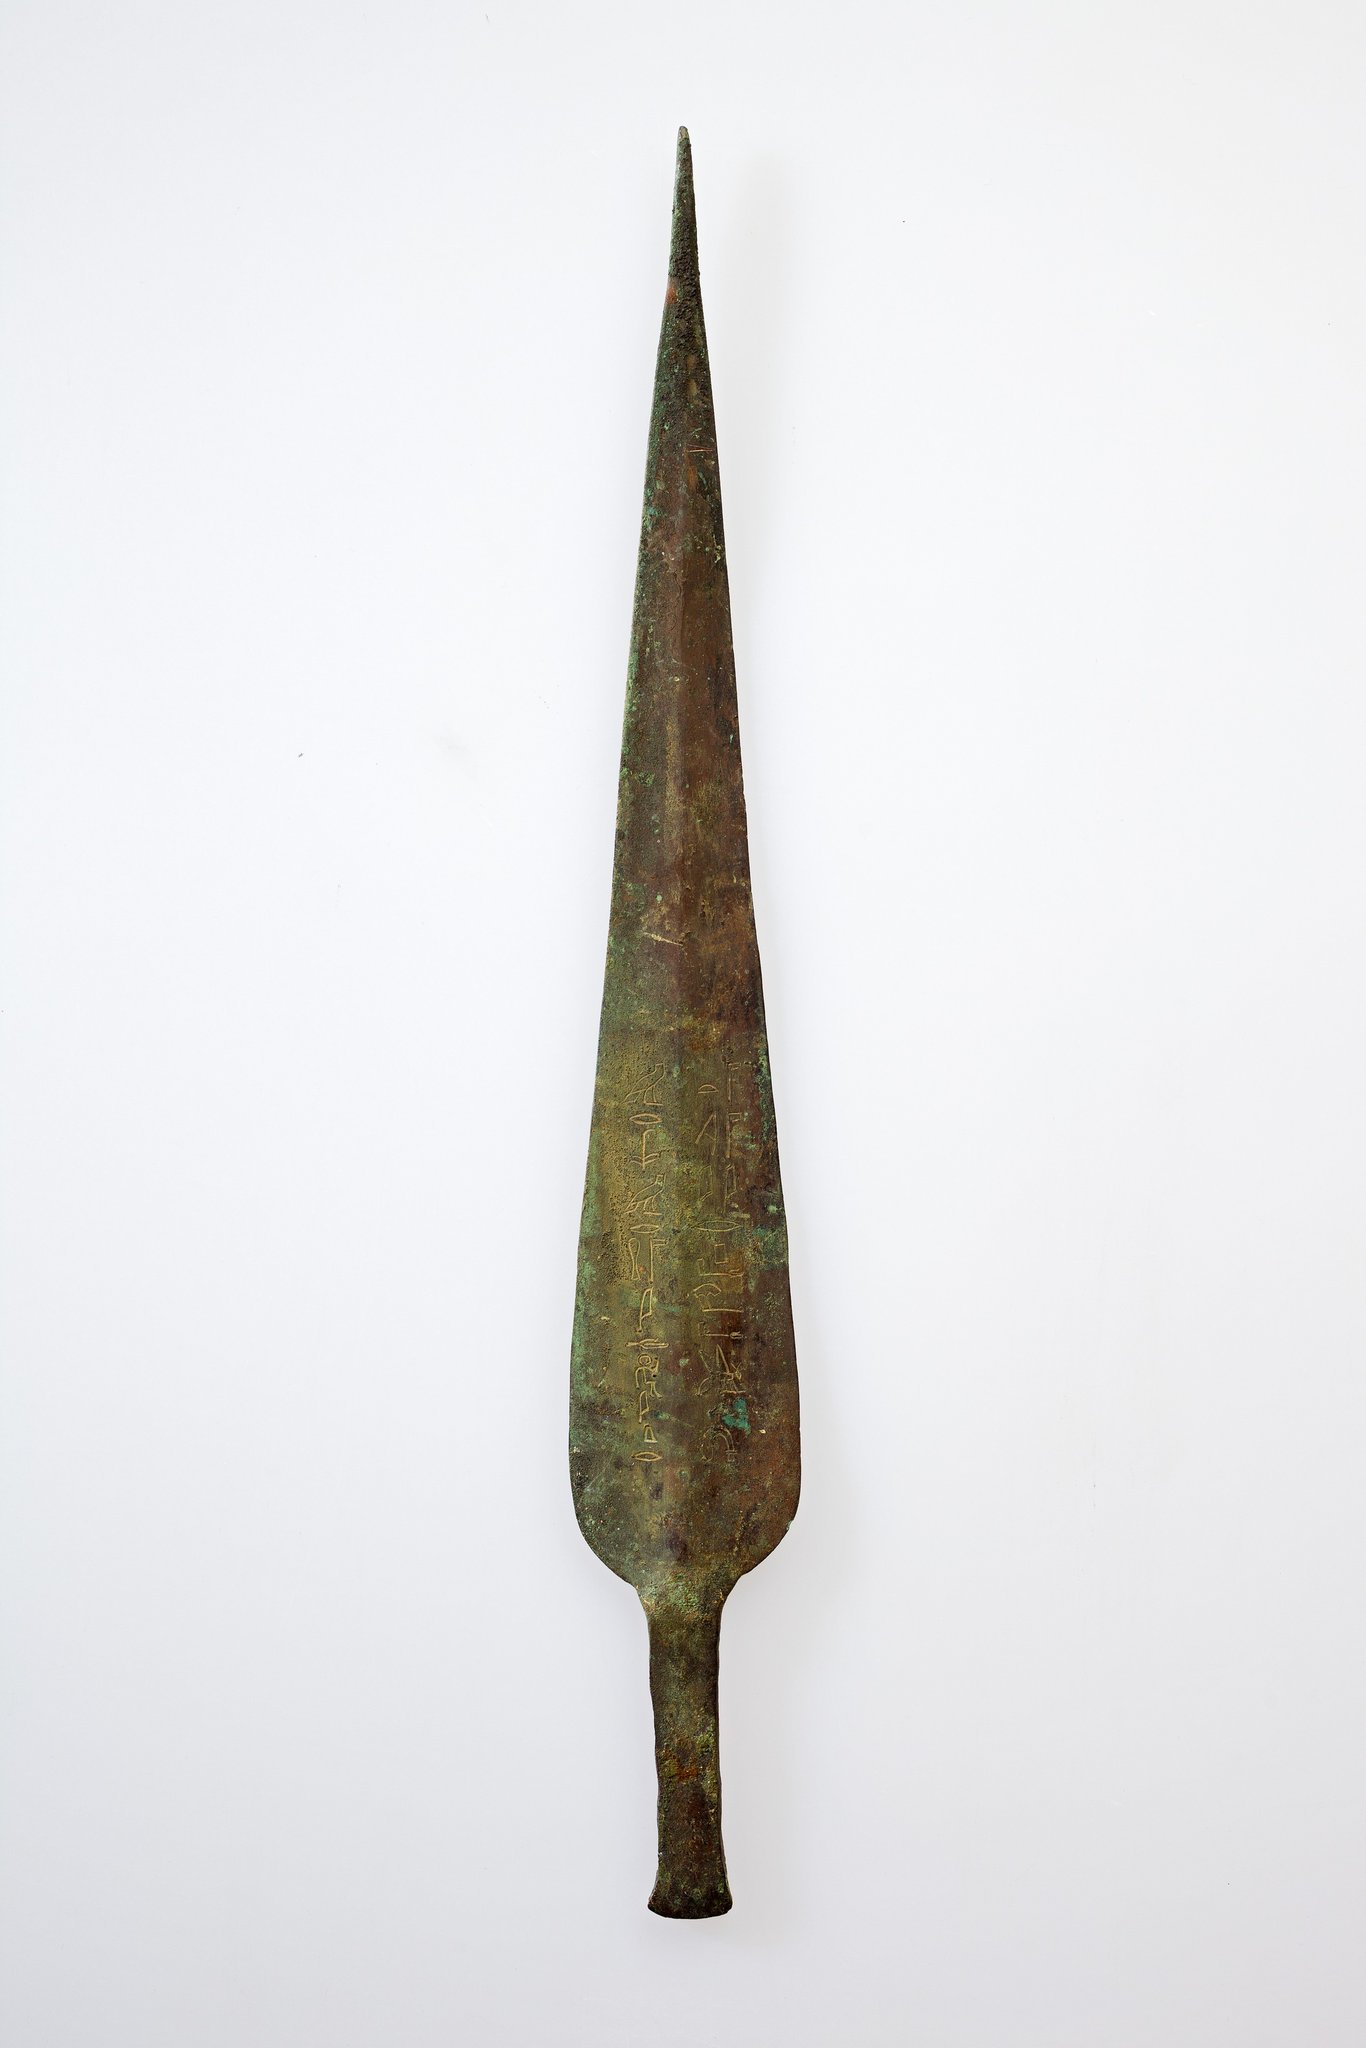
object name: knife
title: Blade inscribed for the Overseer of Upper Egypt Idi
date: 2100 BCE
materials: copper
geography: middle egypt